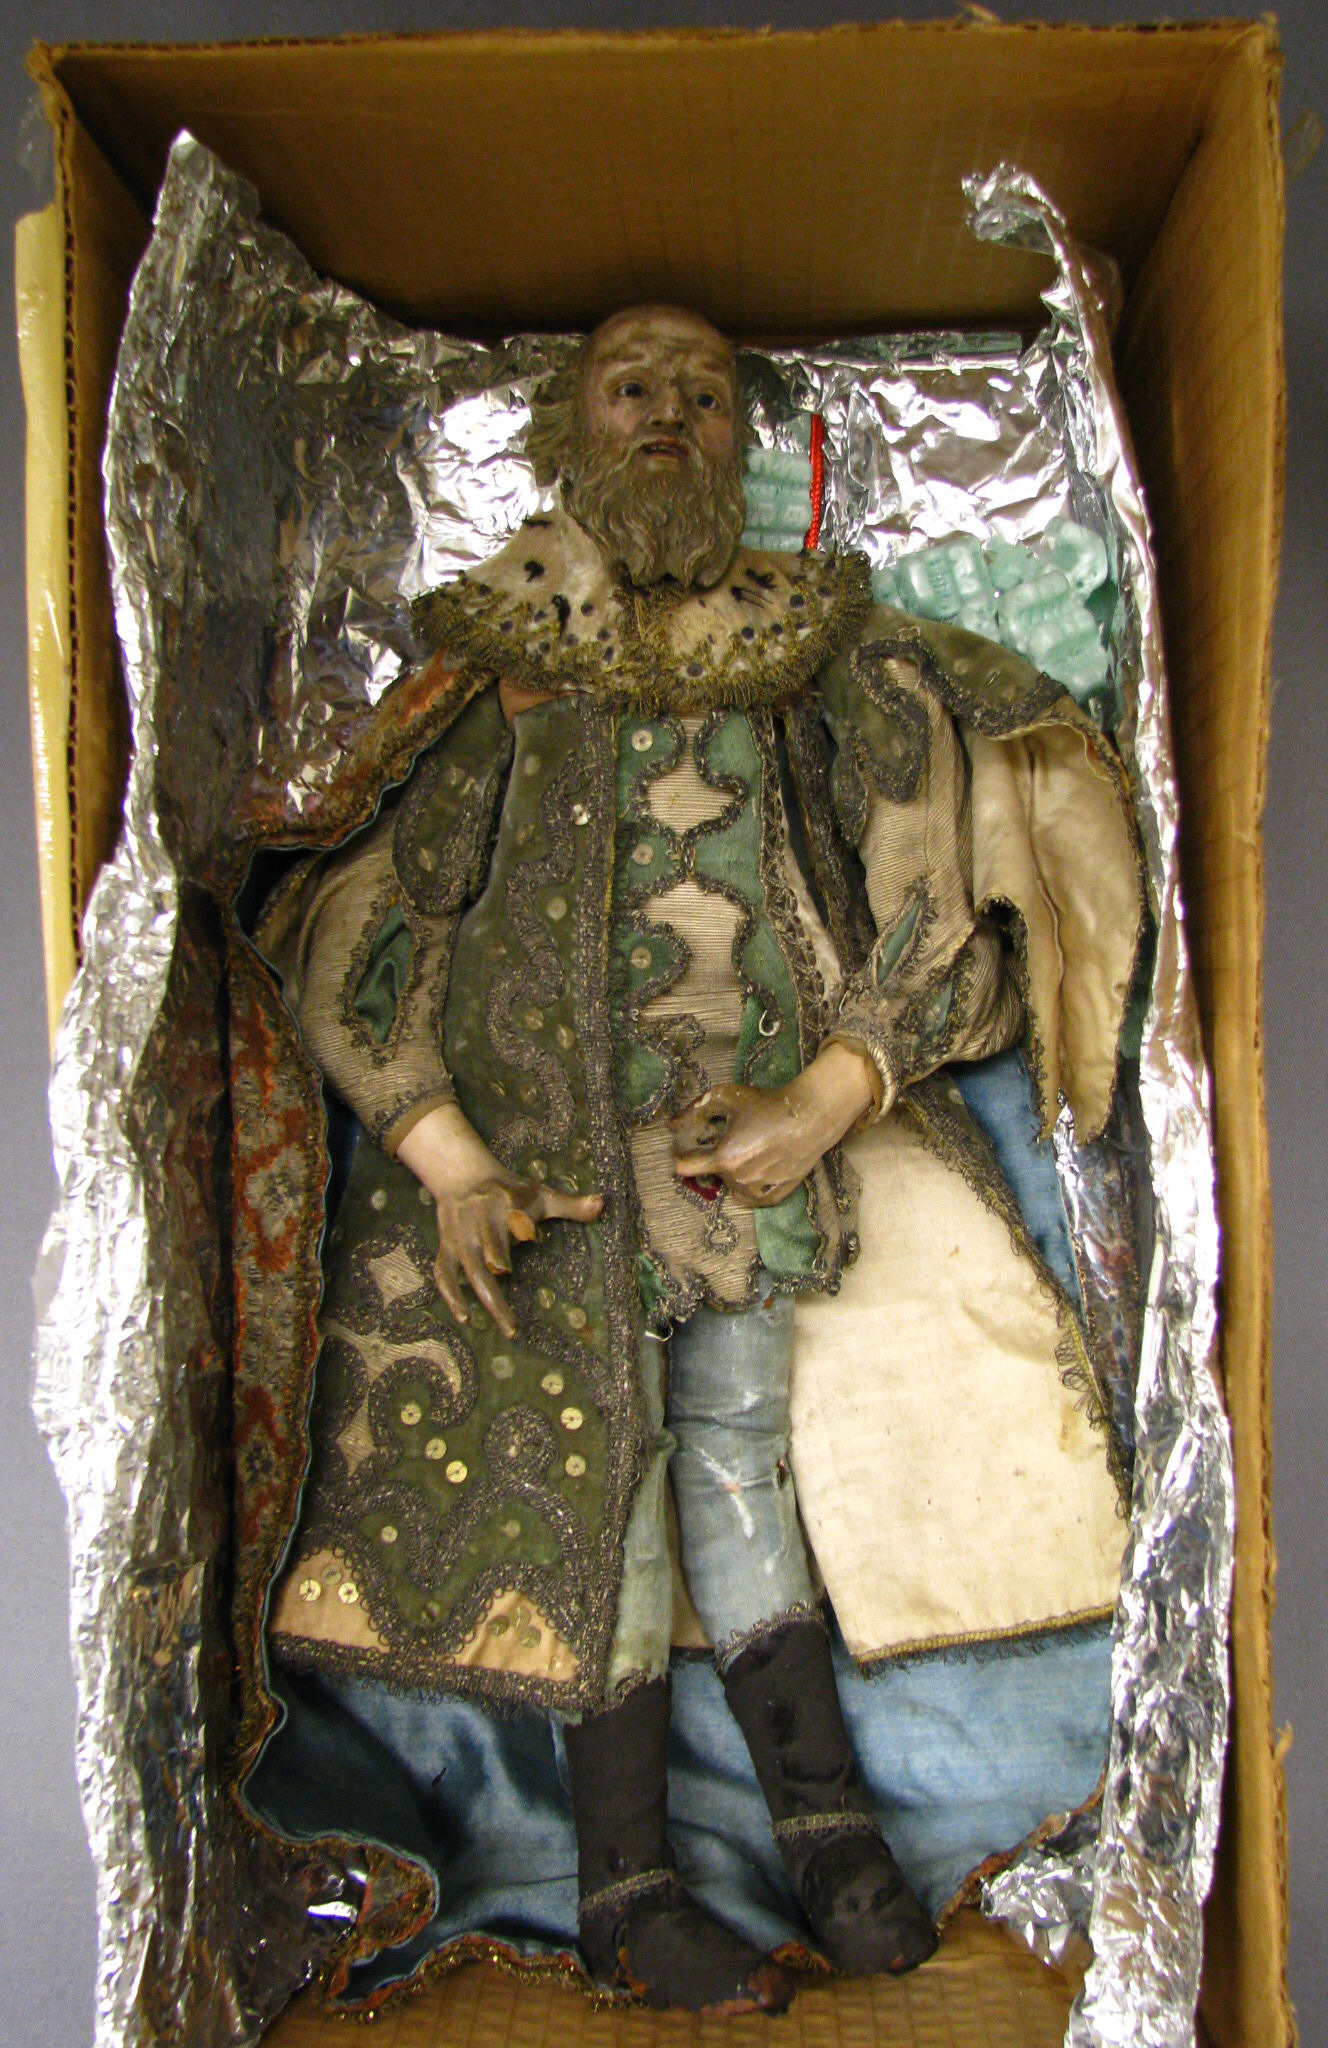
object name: crèche figure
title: Old king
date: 1701-1800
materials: glass, textile, silk, velvet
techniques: polychrome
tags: kings,men